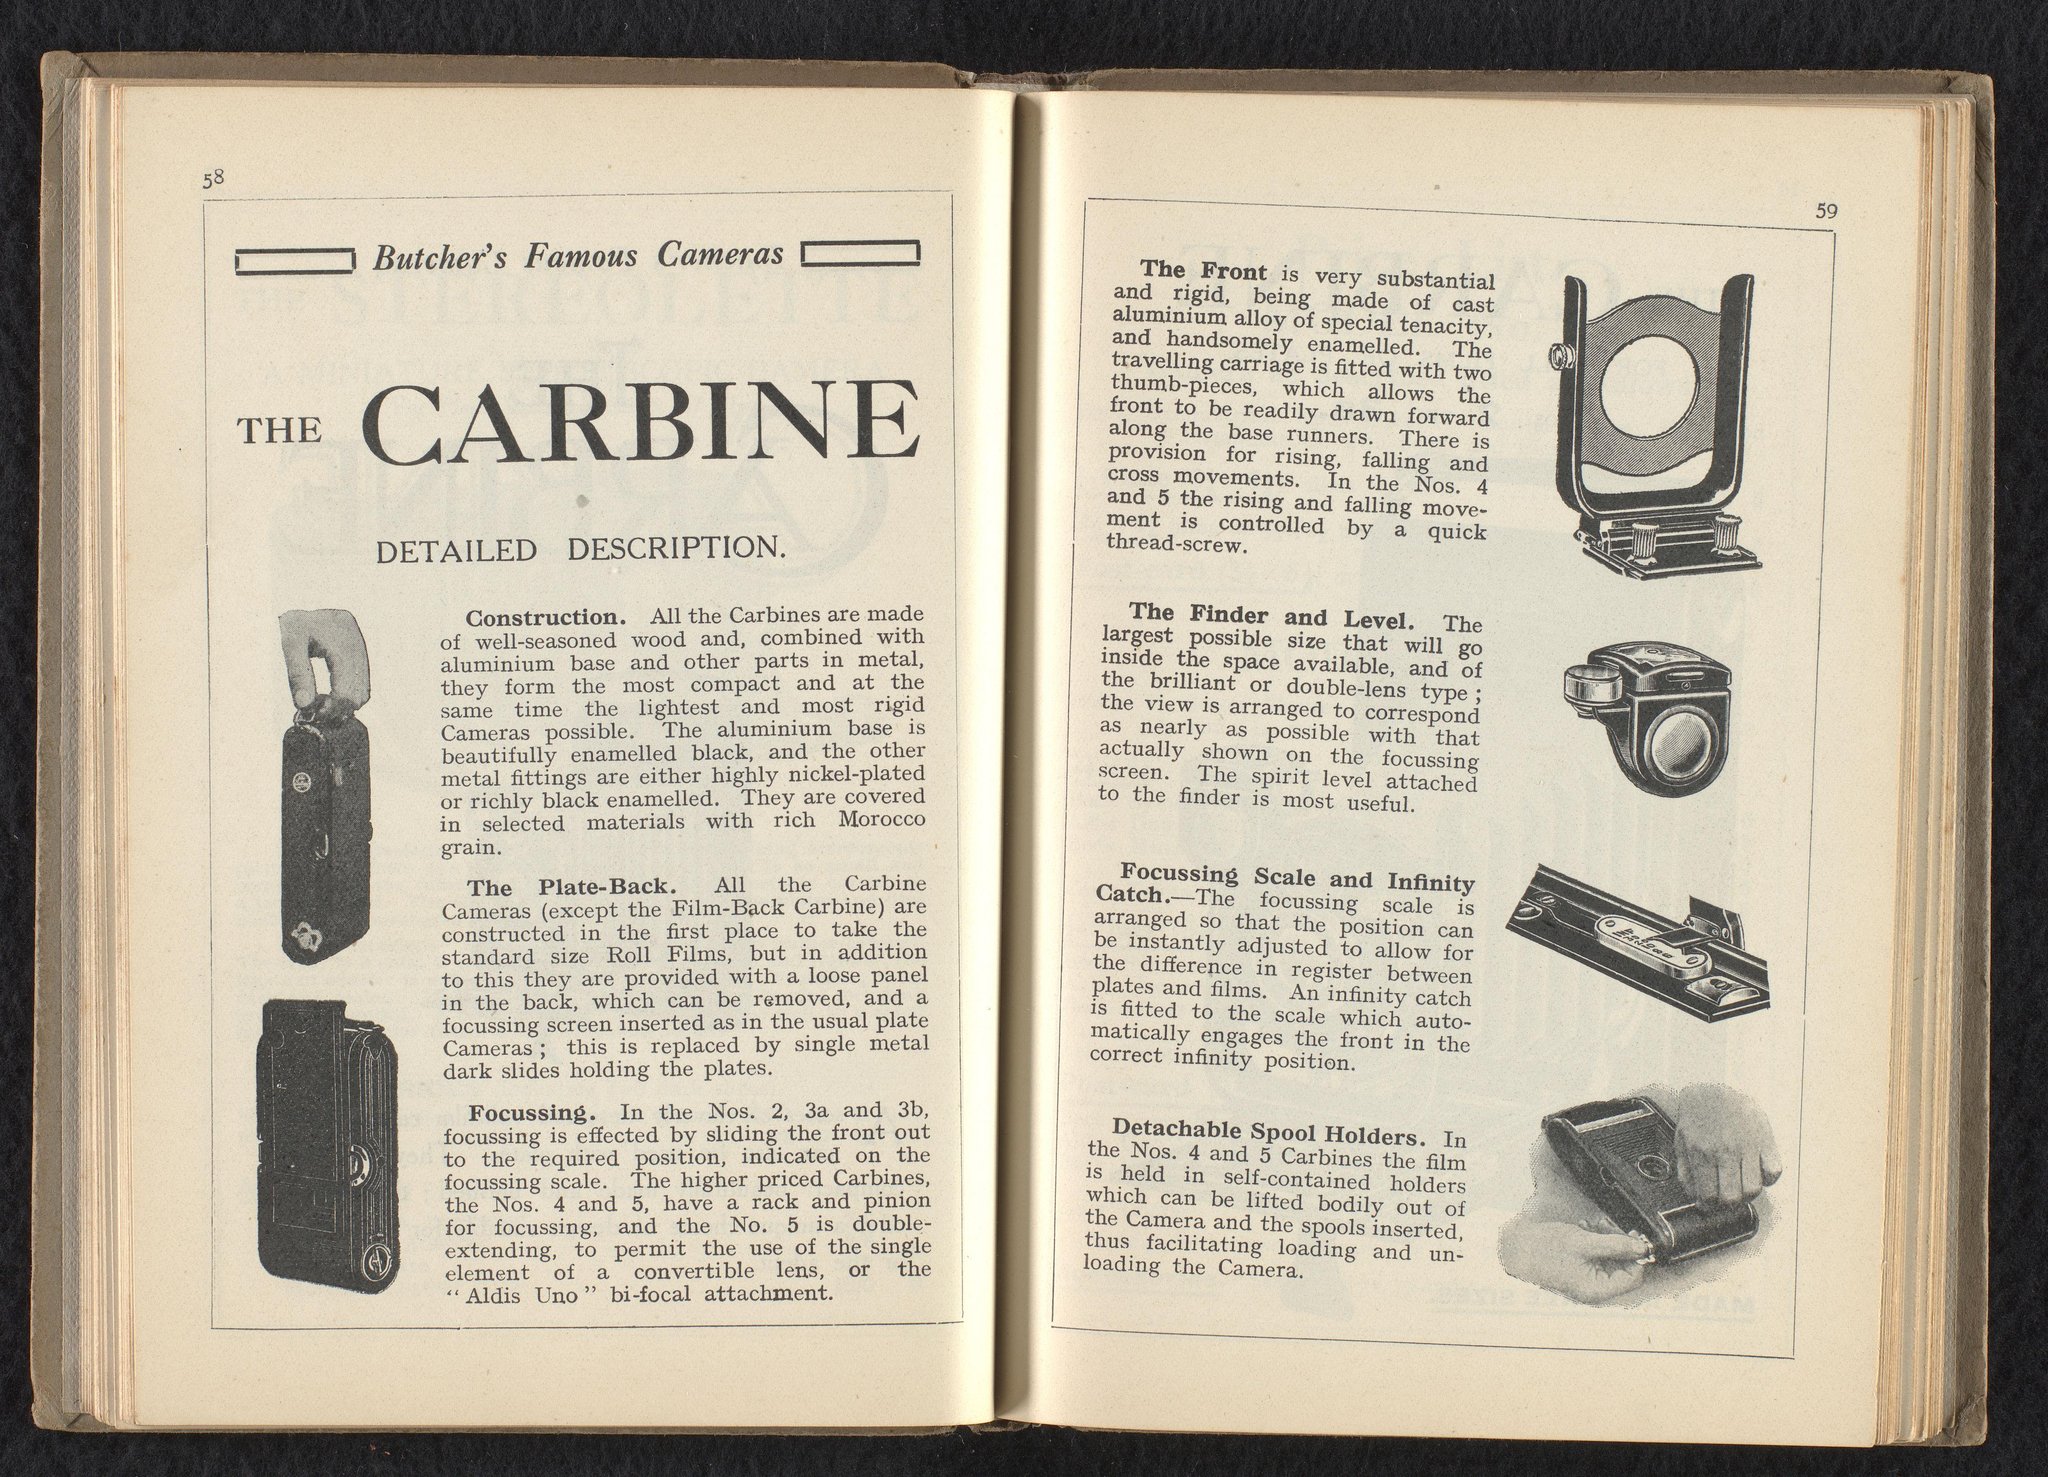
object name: page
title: Opgevouwen Carbine camera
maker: Anonymous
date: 1907-1912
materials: paper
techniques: letterpress printing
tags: camera ~ photography